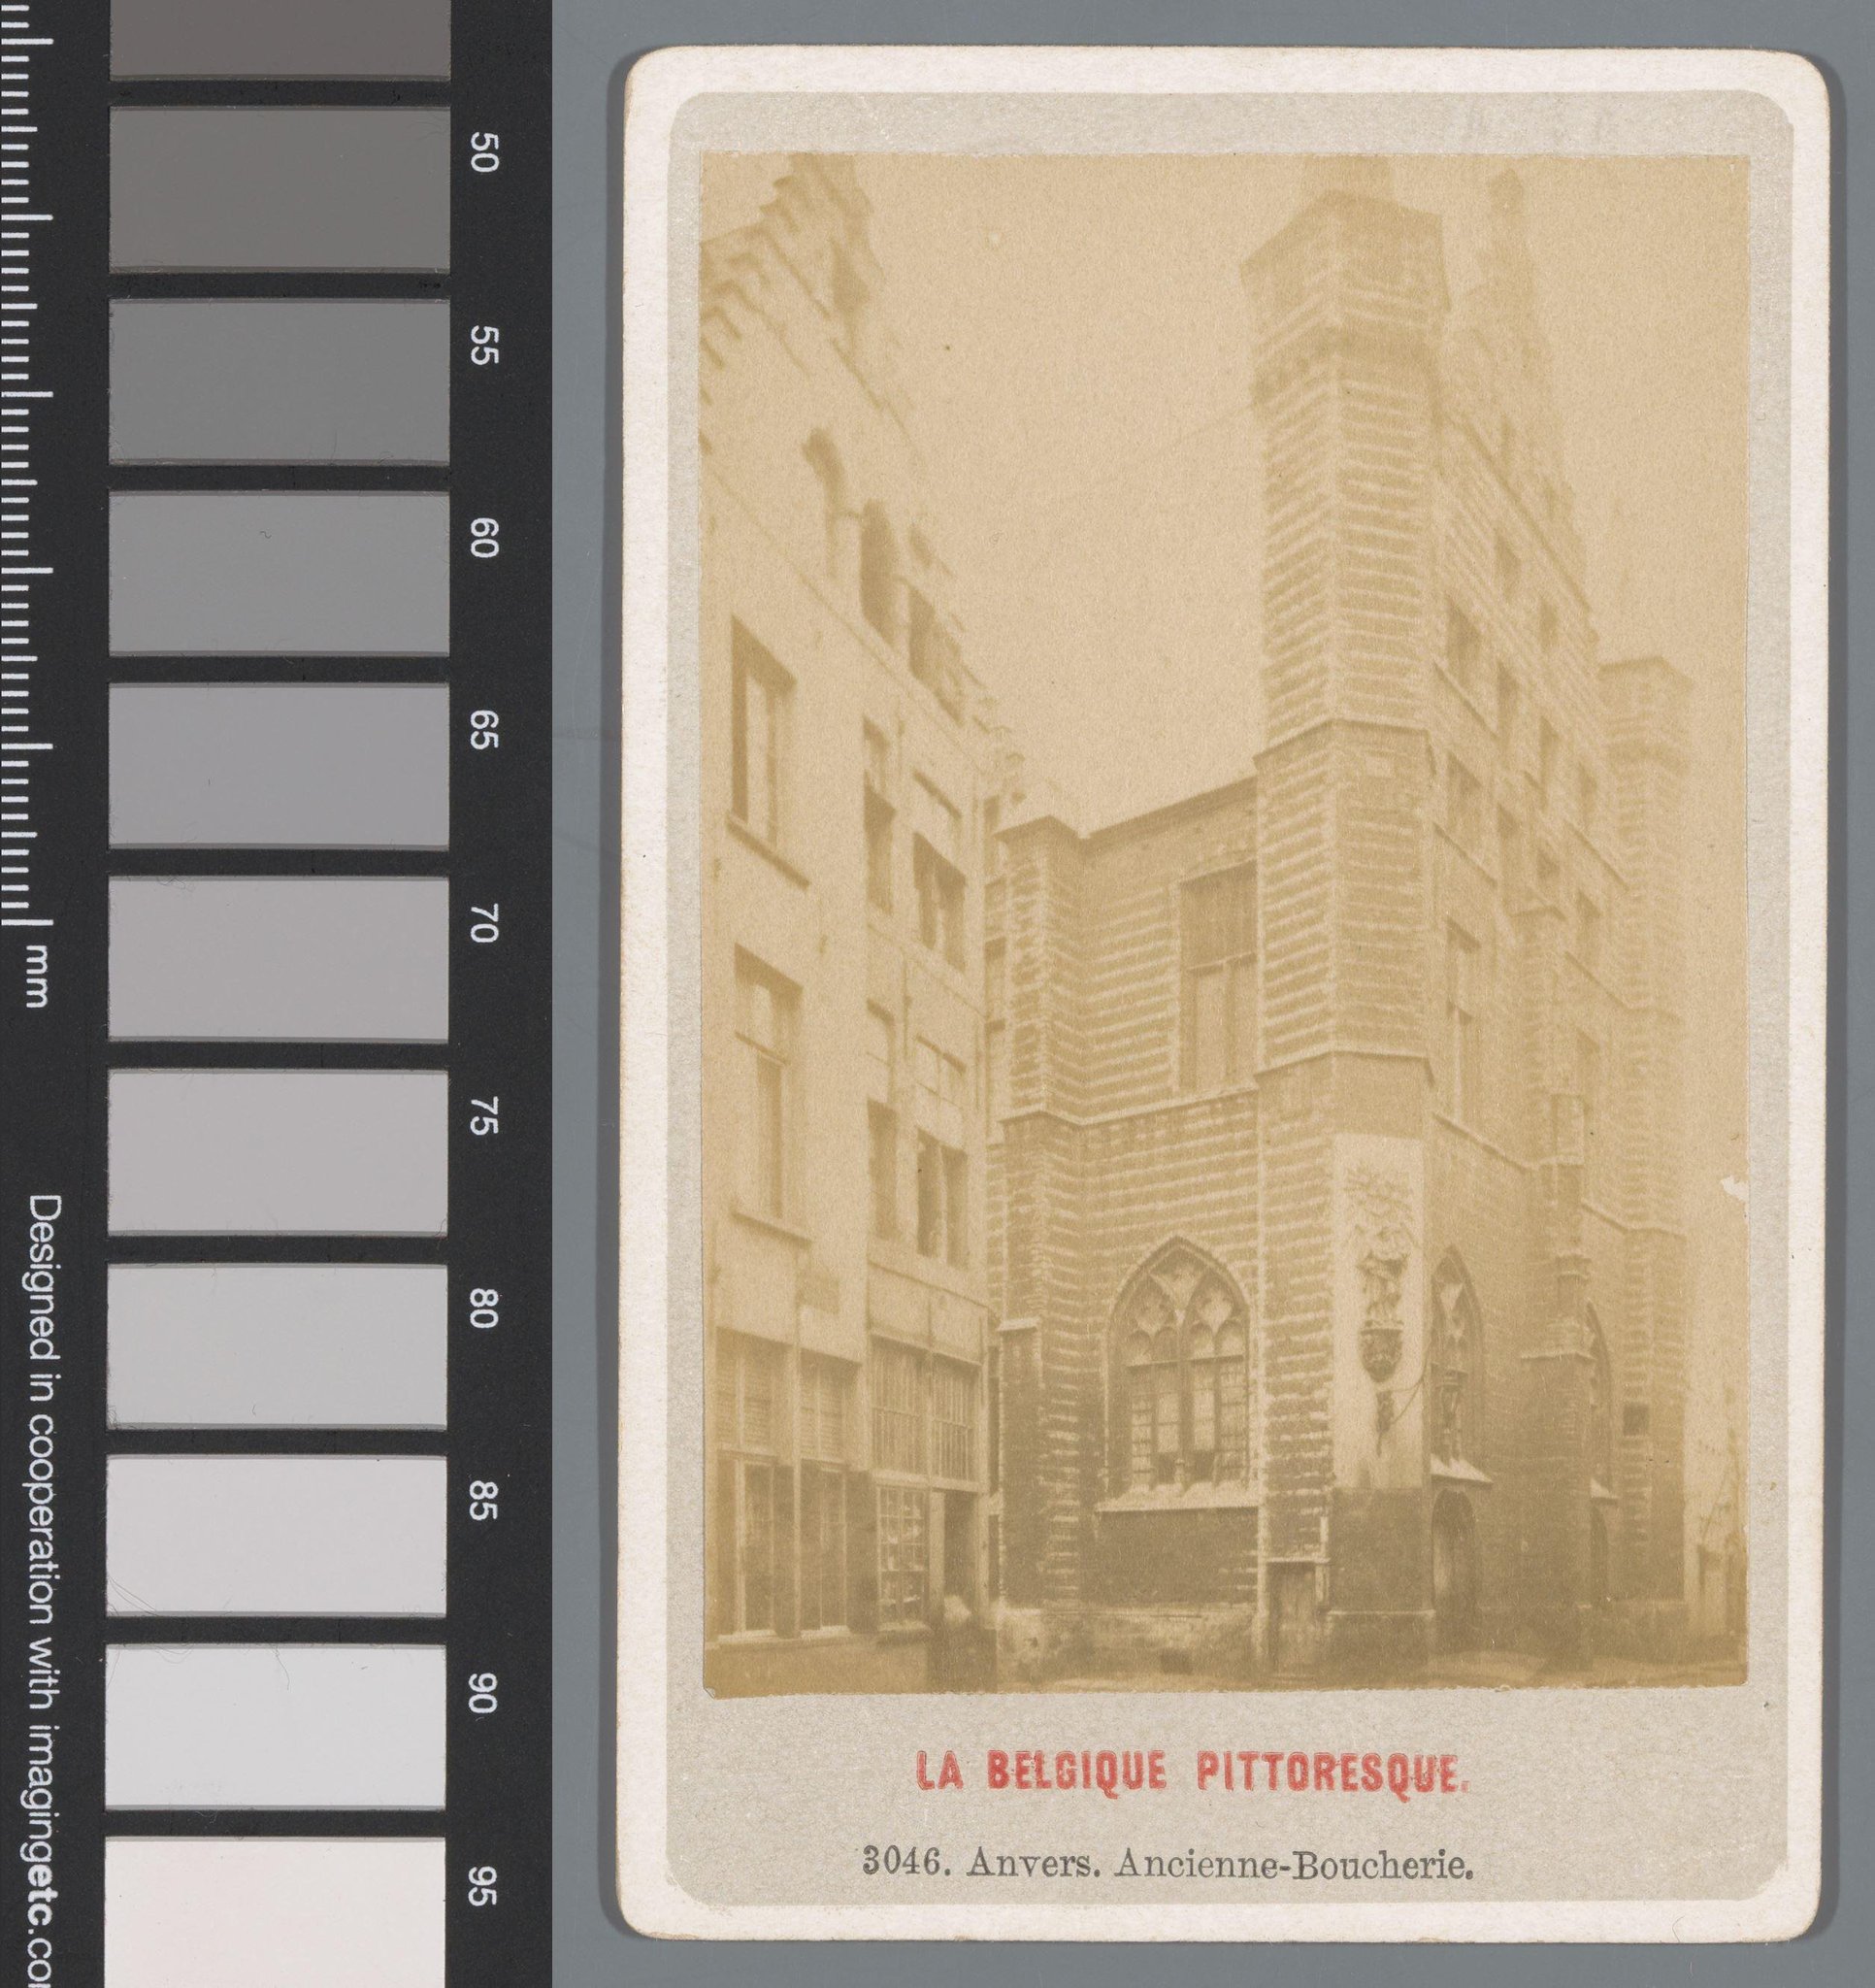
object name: photograph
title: Anvers. Ancienne-Boucherie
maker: Anonymous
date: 1866-1906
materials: cardboard, paper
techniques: albumen print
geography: antwerp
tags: guildhall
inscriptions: inscription: ‘Ancienne maison F. Tessaro/ G. Zazzarini & Cie, Successeurs/ 37, Marché aux Souliers/ Anvers’, number: ‘3046.’